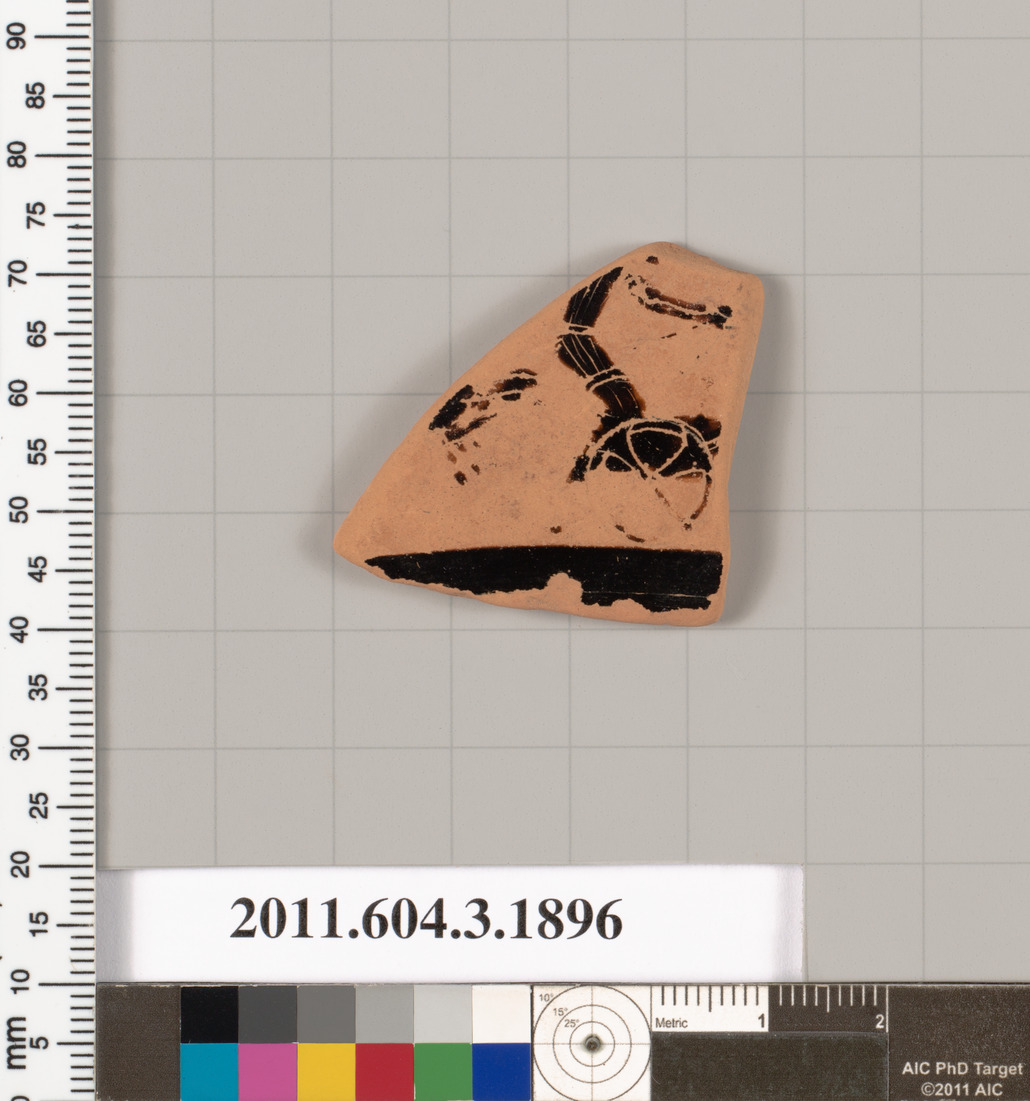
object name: kylix fragment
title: Terracotta fragment of a kylix: Band cup (drinking cup)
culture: greek, attic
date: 550-526 BCE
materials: terracotta